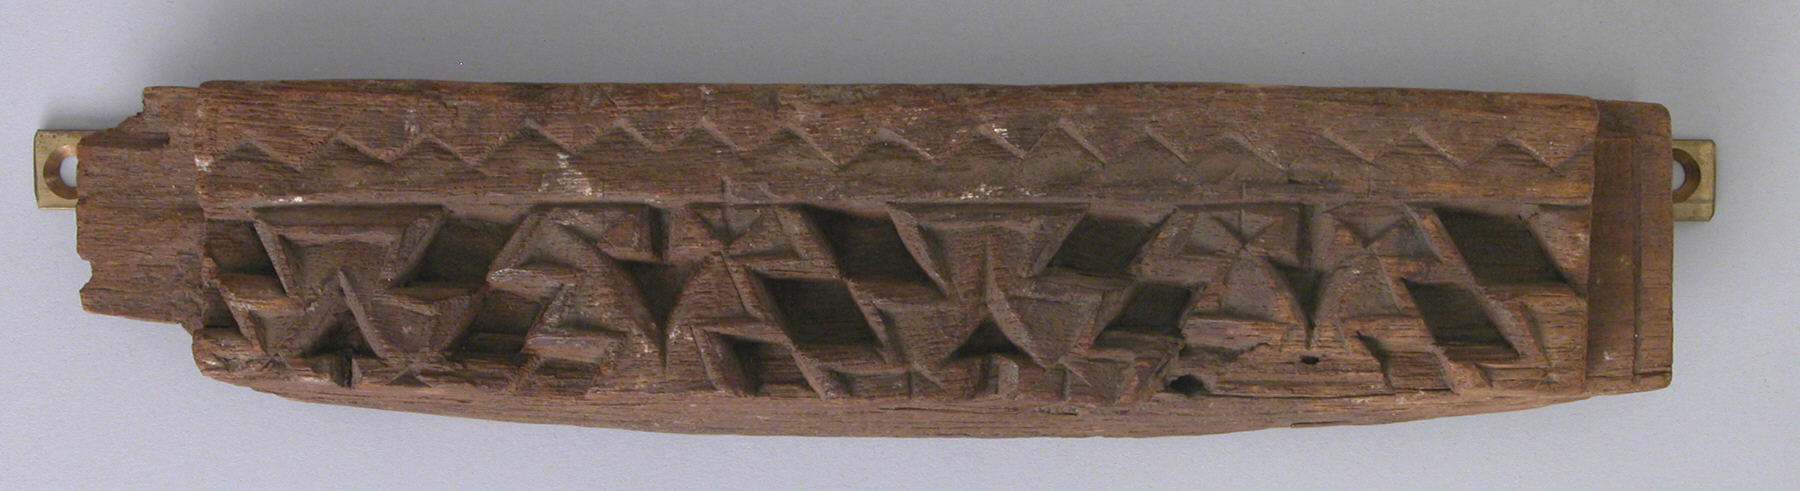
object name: panel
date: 701-900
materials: wood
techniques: carving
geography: iraq